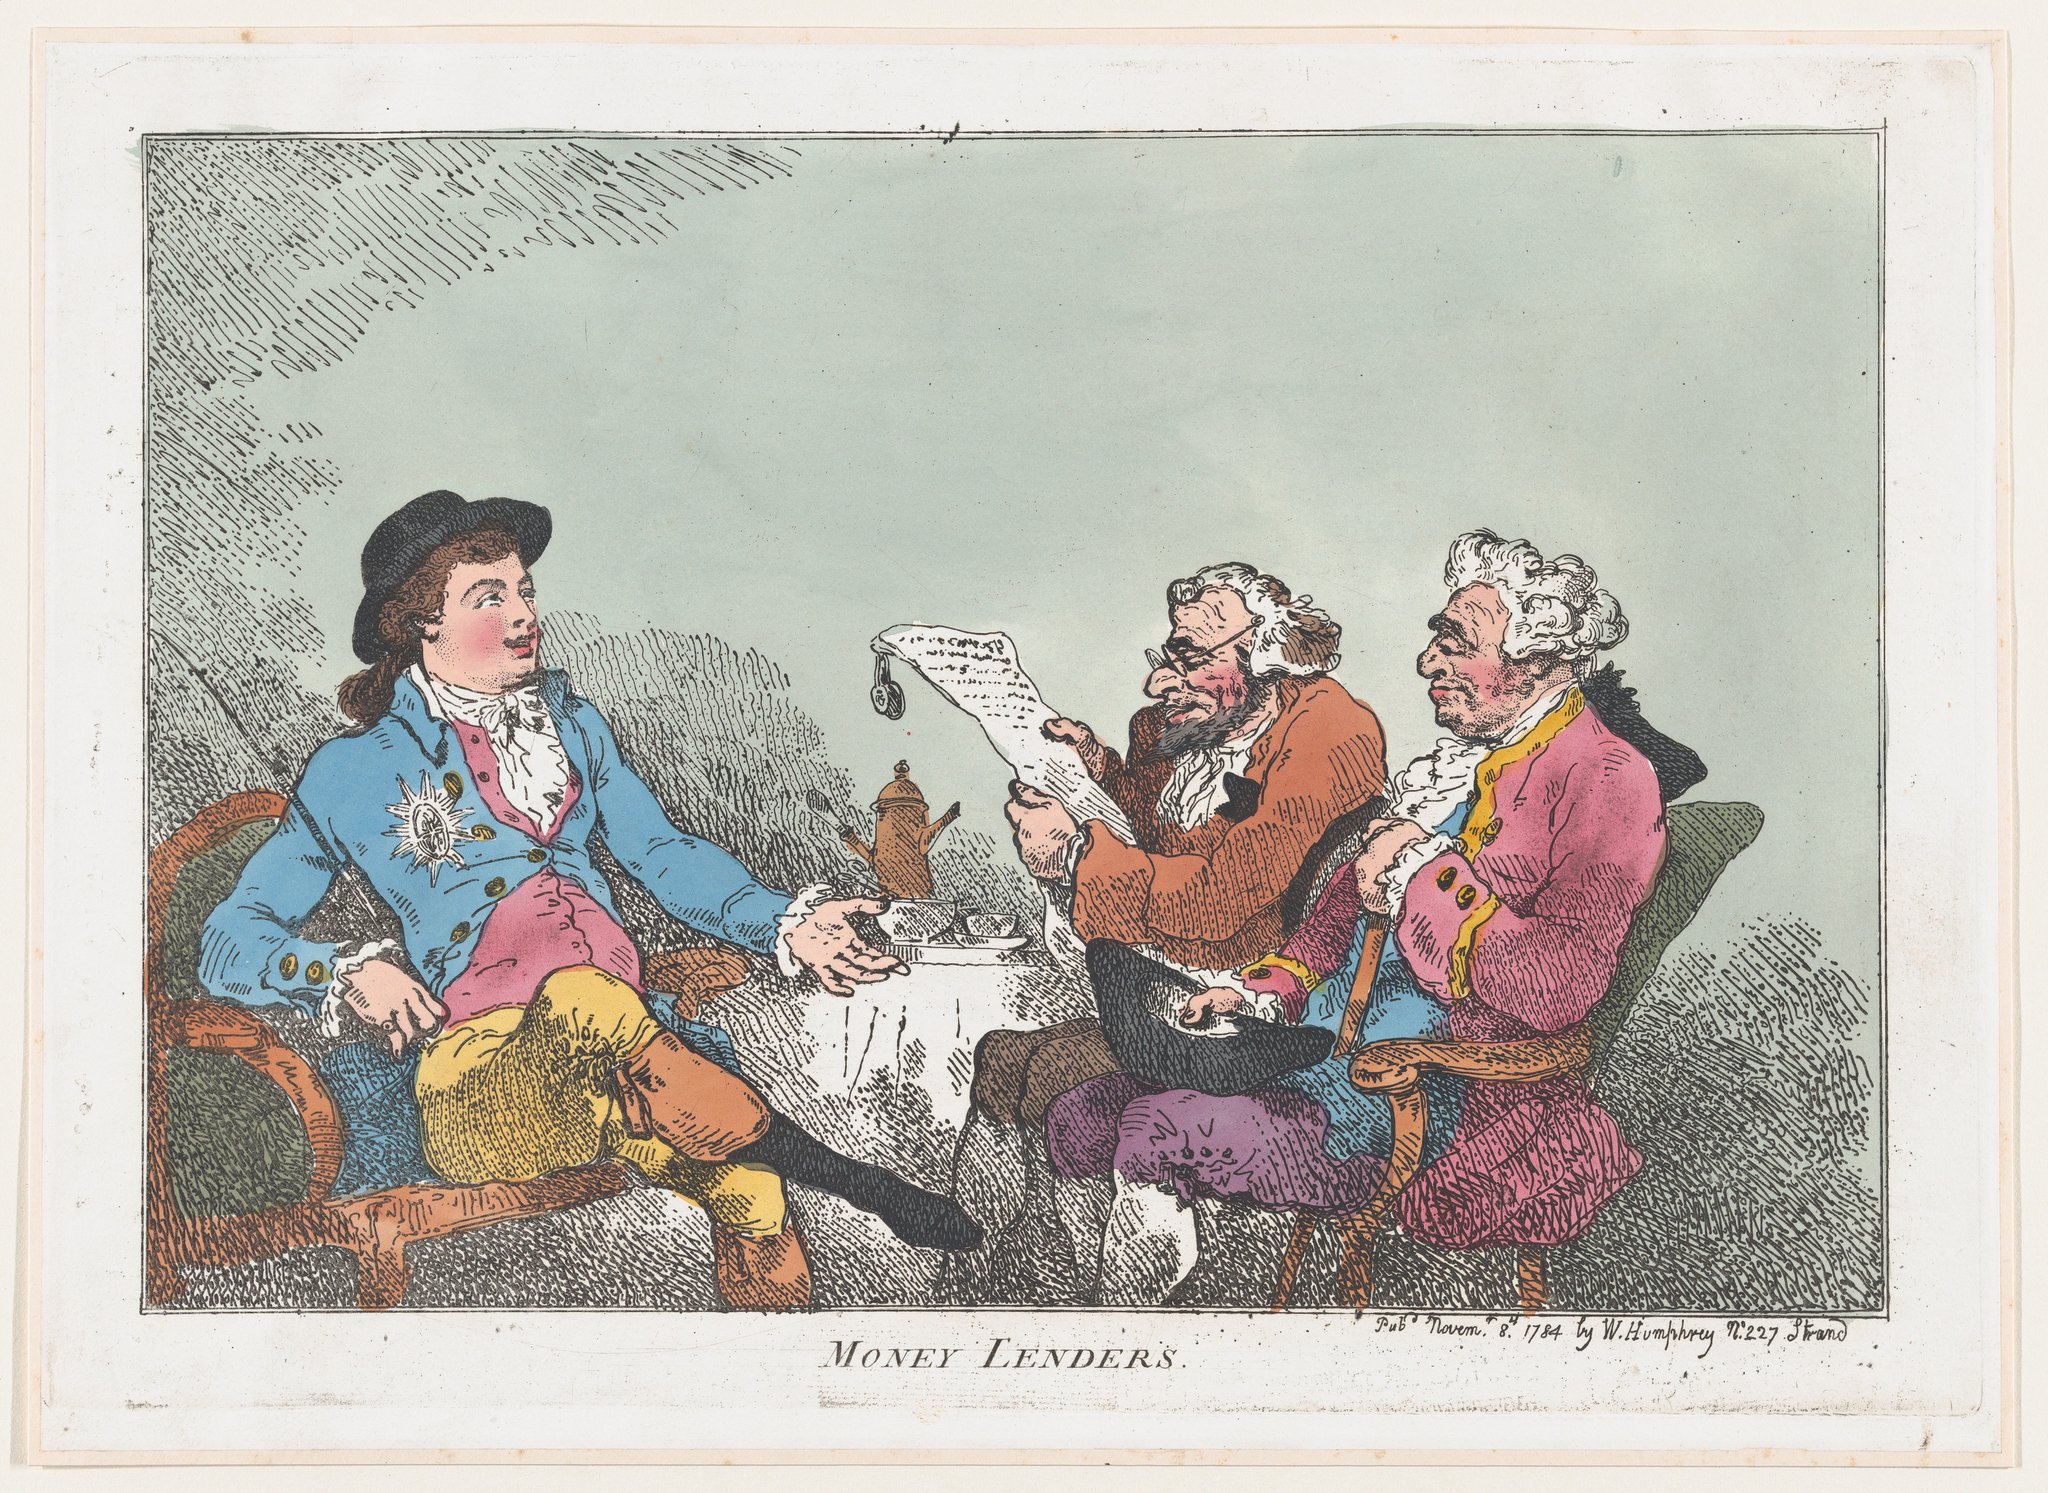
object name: print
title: Money Lenders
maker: thomas rowlandson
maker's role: artist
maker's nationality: british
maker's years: 1757-1827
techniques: etching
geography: london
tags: satire,men,reading